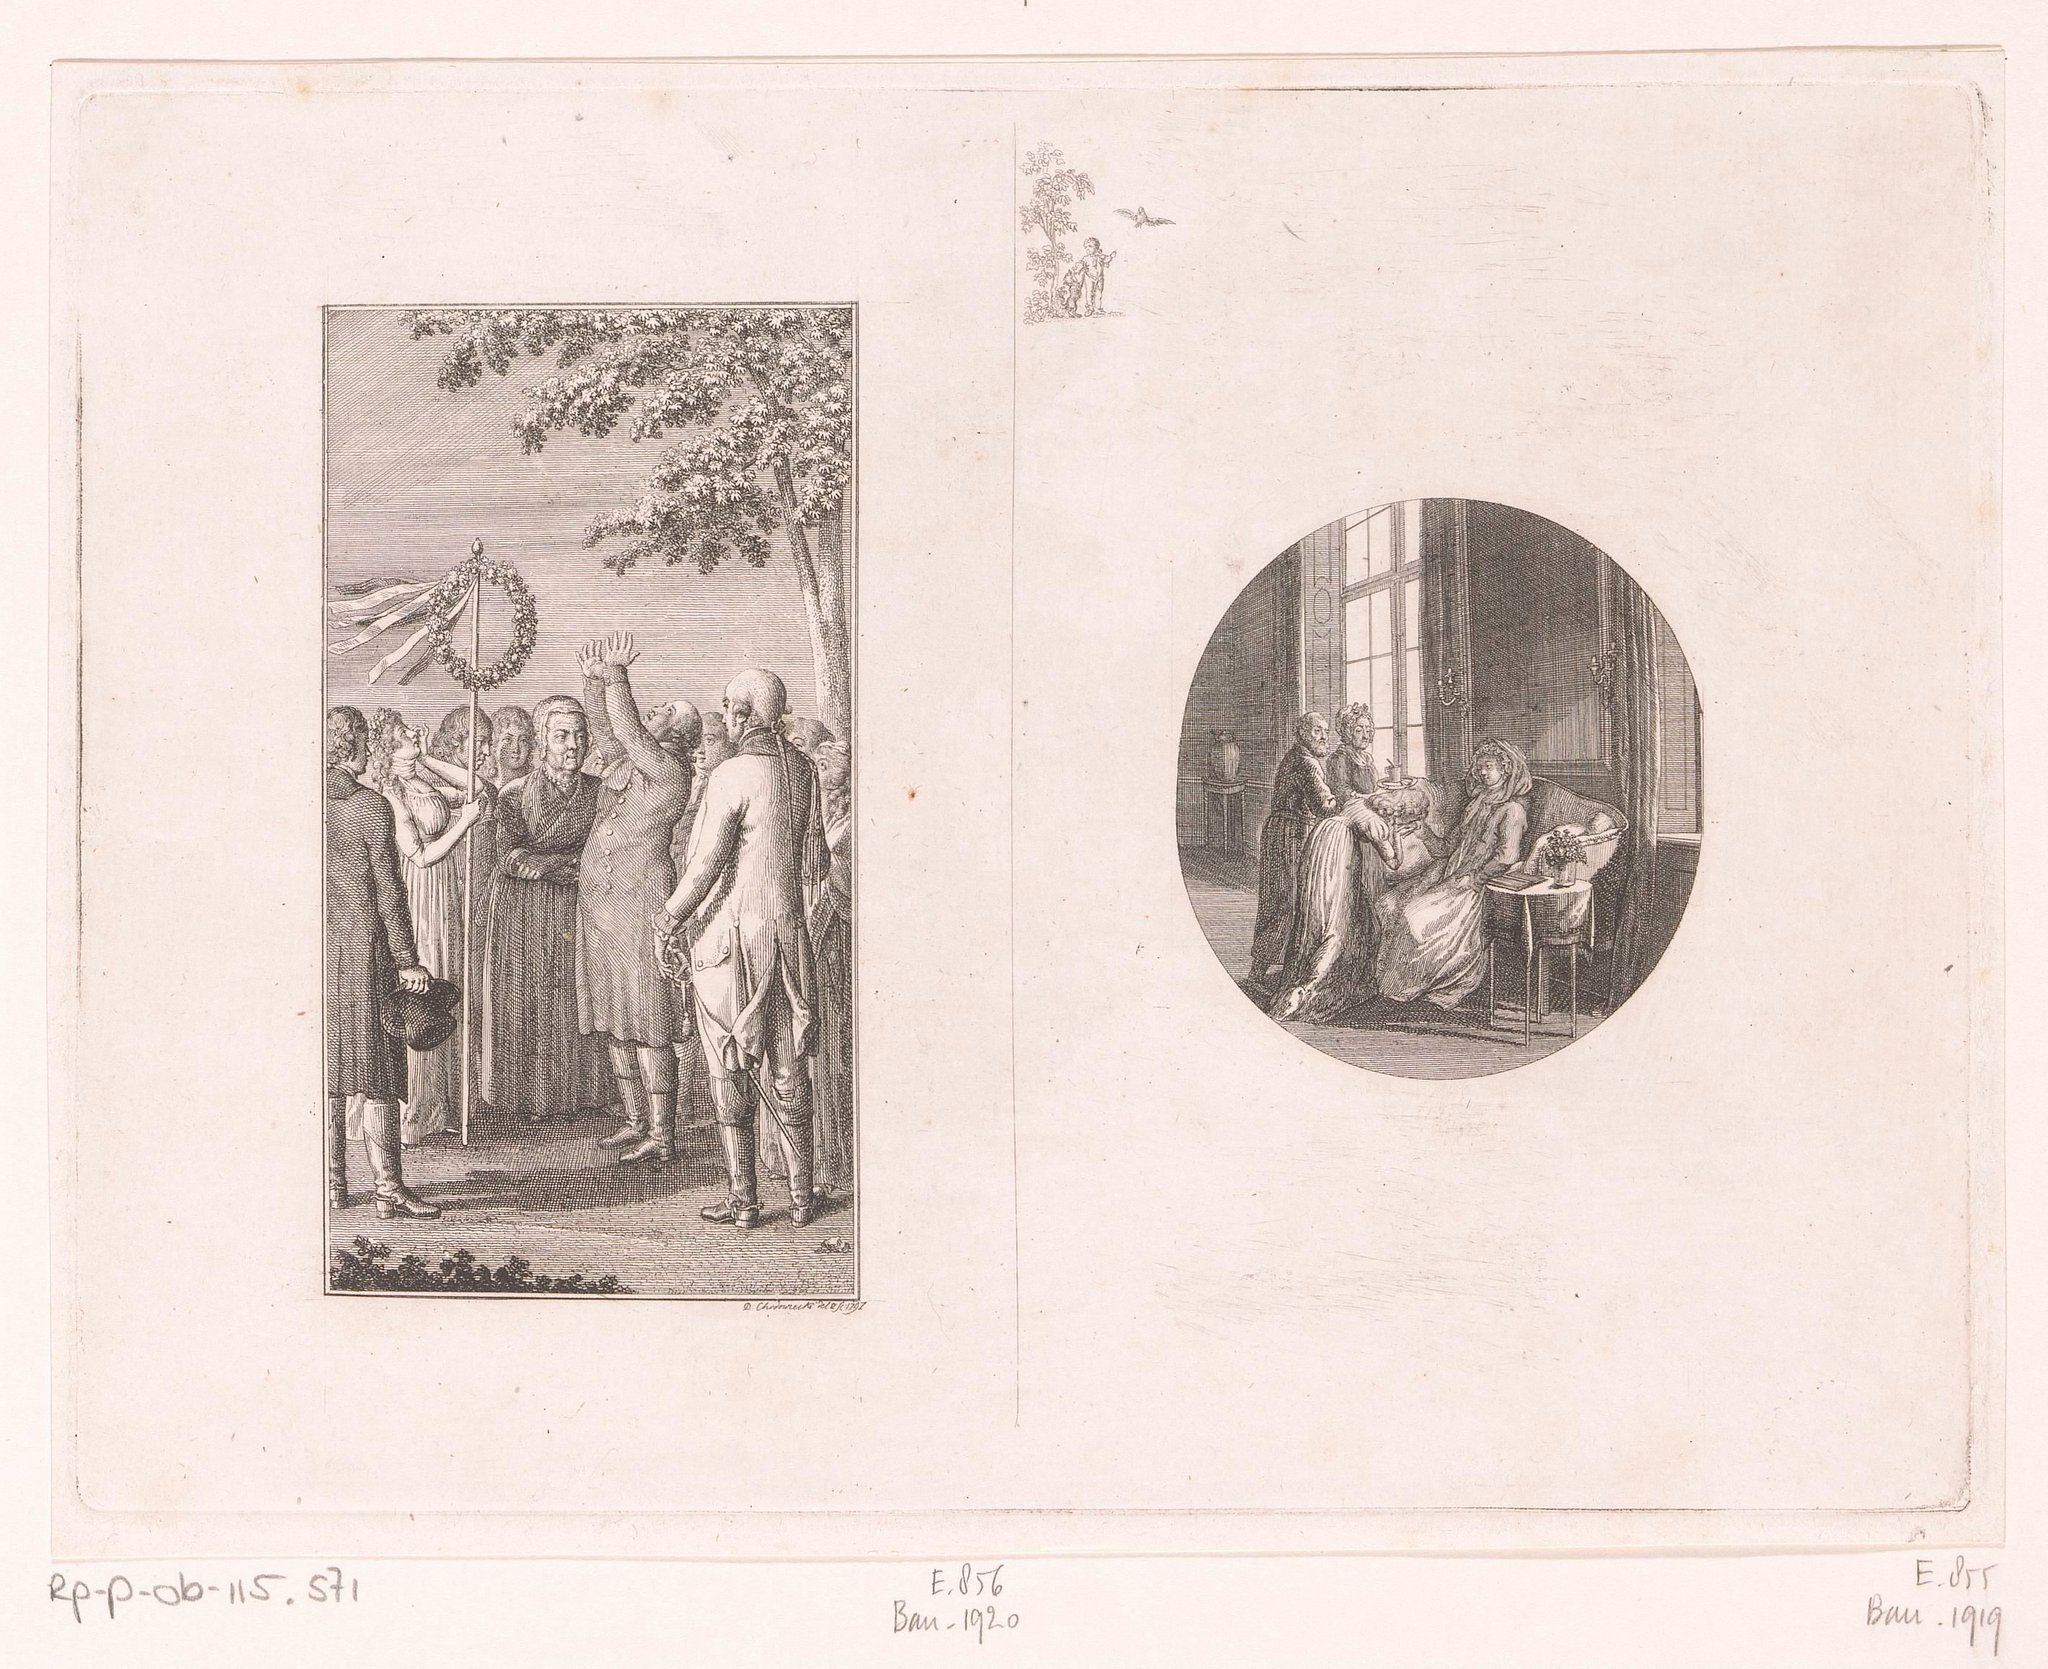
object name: print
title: Twee voorstellingen uit Julchen Grünthal van Friederike Helene Unger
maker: daniel nikolaus chodowiecki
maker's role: draughtsman, print maker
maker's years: 1726-1801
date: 1797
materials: paper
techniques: etching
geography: berlin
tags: garland, wreath, arm raised upward - aa - both arms or hands, weeping, priests ~ hierarchy of priests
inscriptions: collector's mark: Lugt 2228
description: Latere staat gebruikt voor: Unger, Friederike Helene. Julchen Grünthal. 2 dln. Berlijn: Johann Friedrich Unger, 1798, dl. 2.